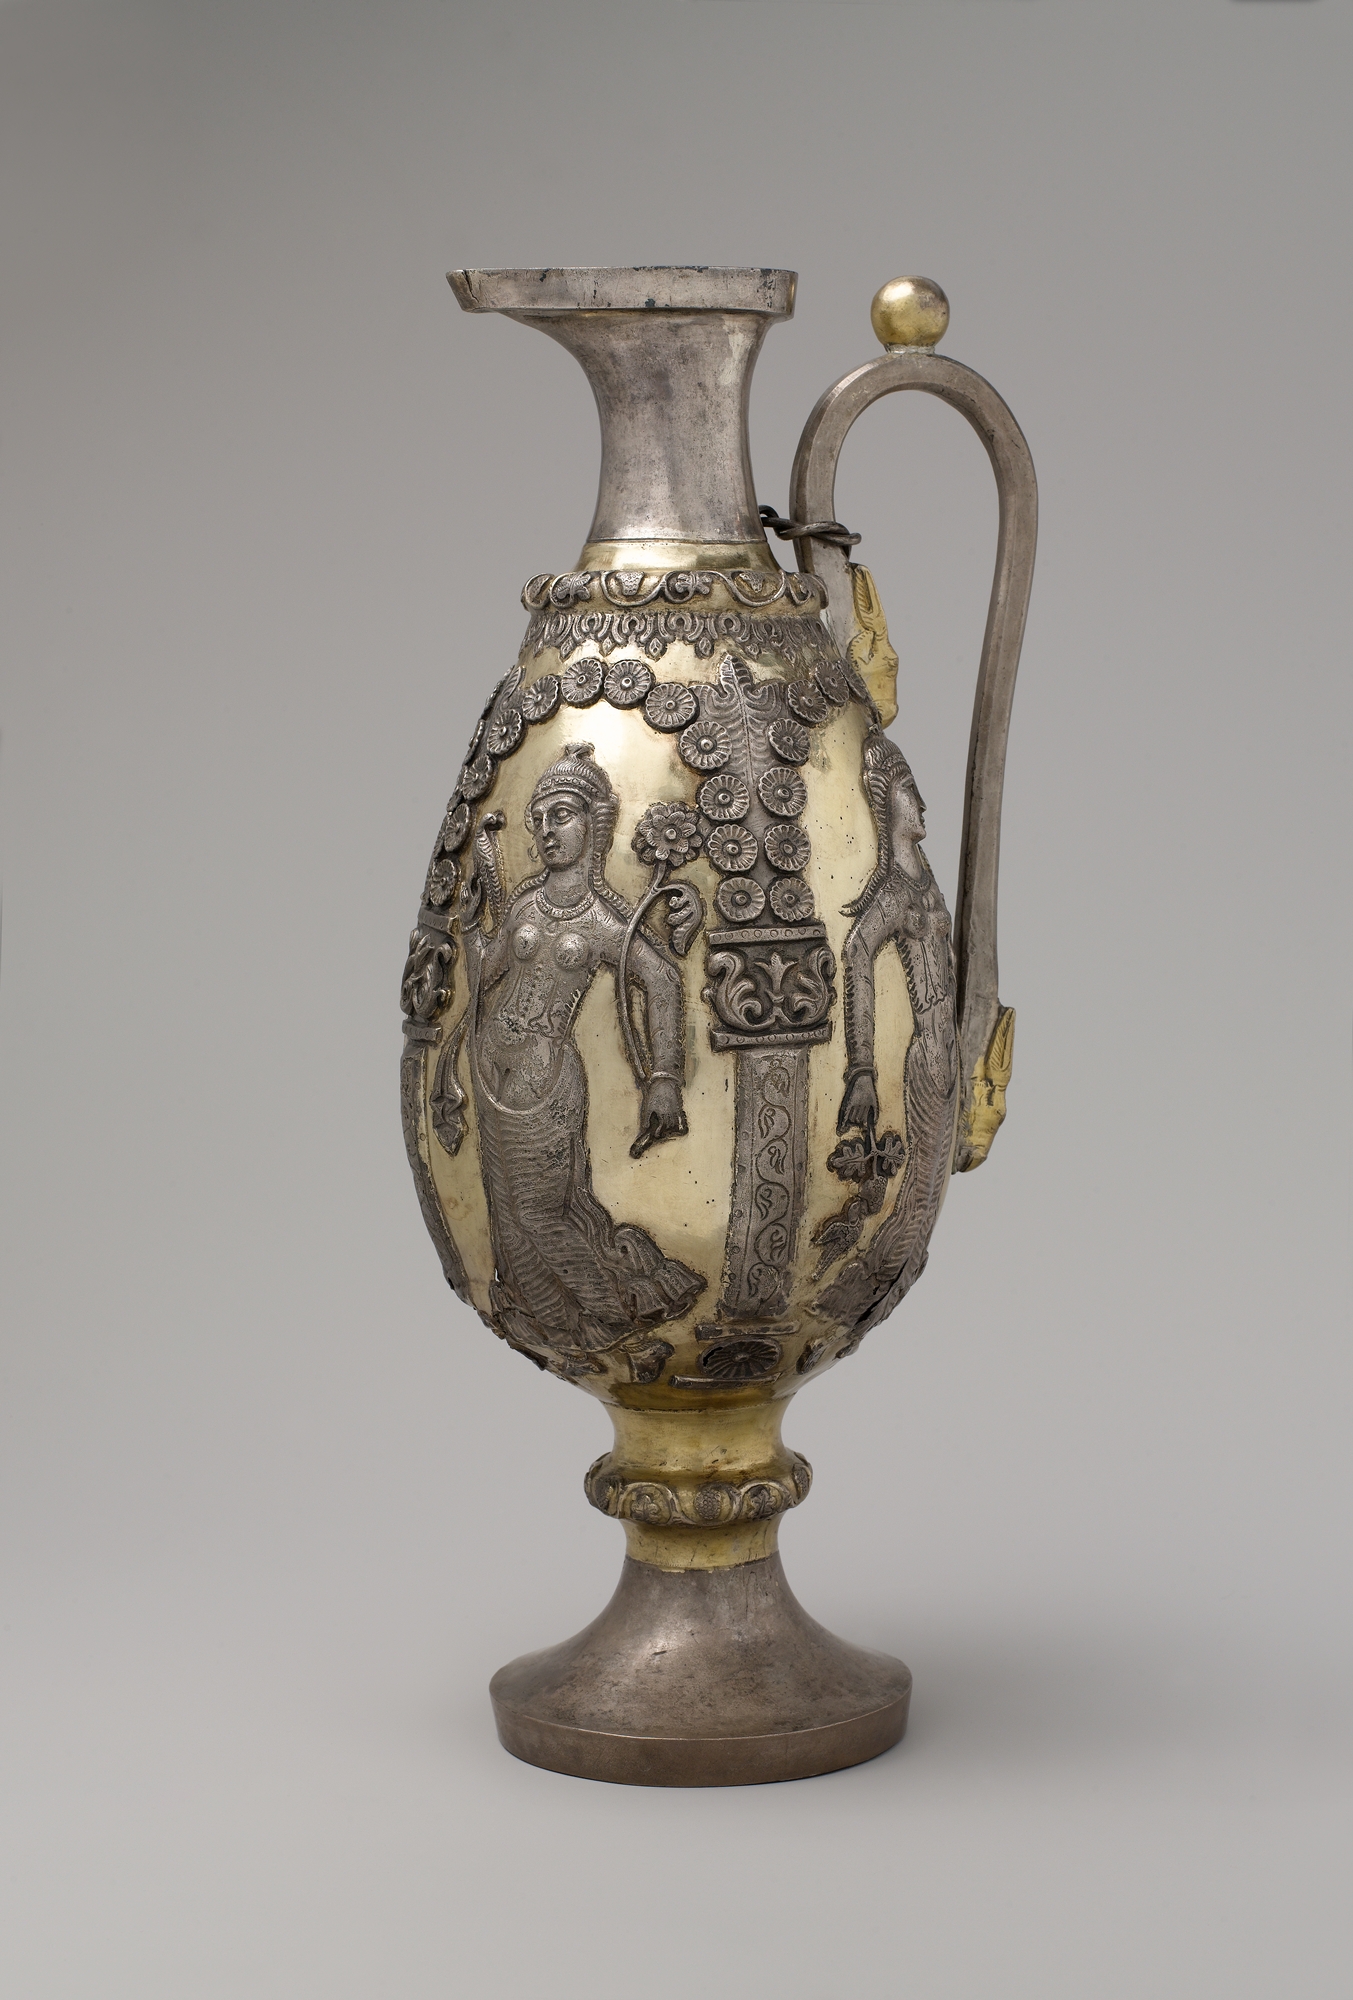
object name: ewer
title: Ewer with dancing females within arcades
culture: sasanian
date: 501-700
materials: mercury, silver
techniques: gilding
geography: iran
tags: women,dancing